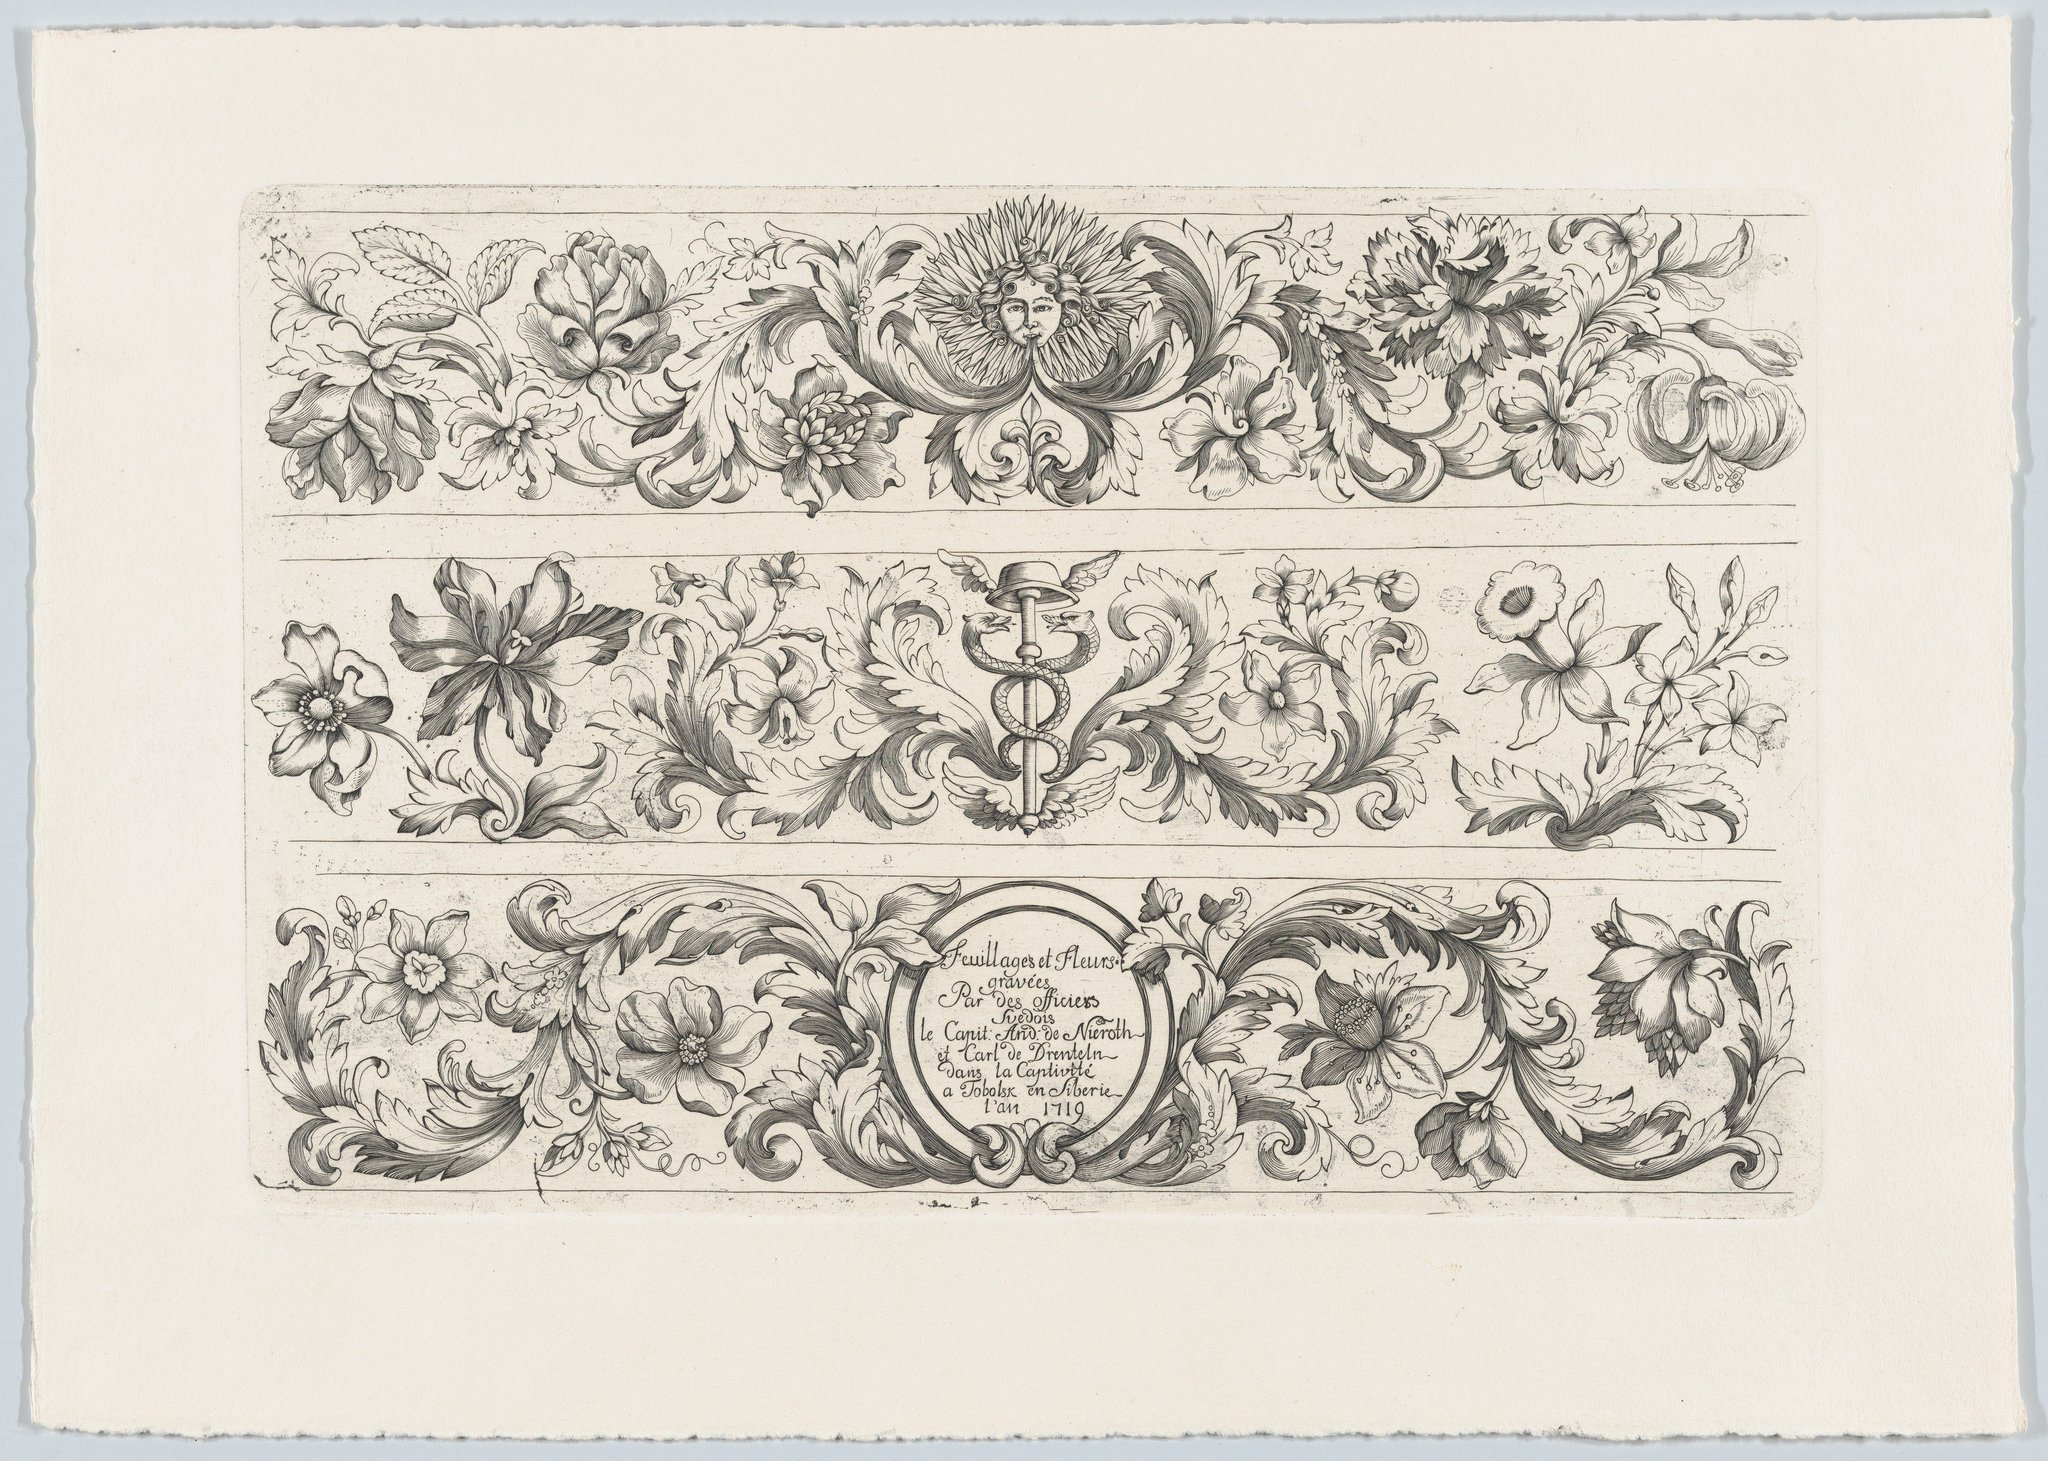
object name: print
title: Foliage and Flowers (Feuillages et Fleurs)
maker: carl ludvig von drenteln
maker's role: artist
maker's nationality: swedish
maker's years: 1692-1753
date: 1719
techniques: engraving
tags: flowers,leaves